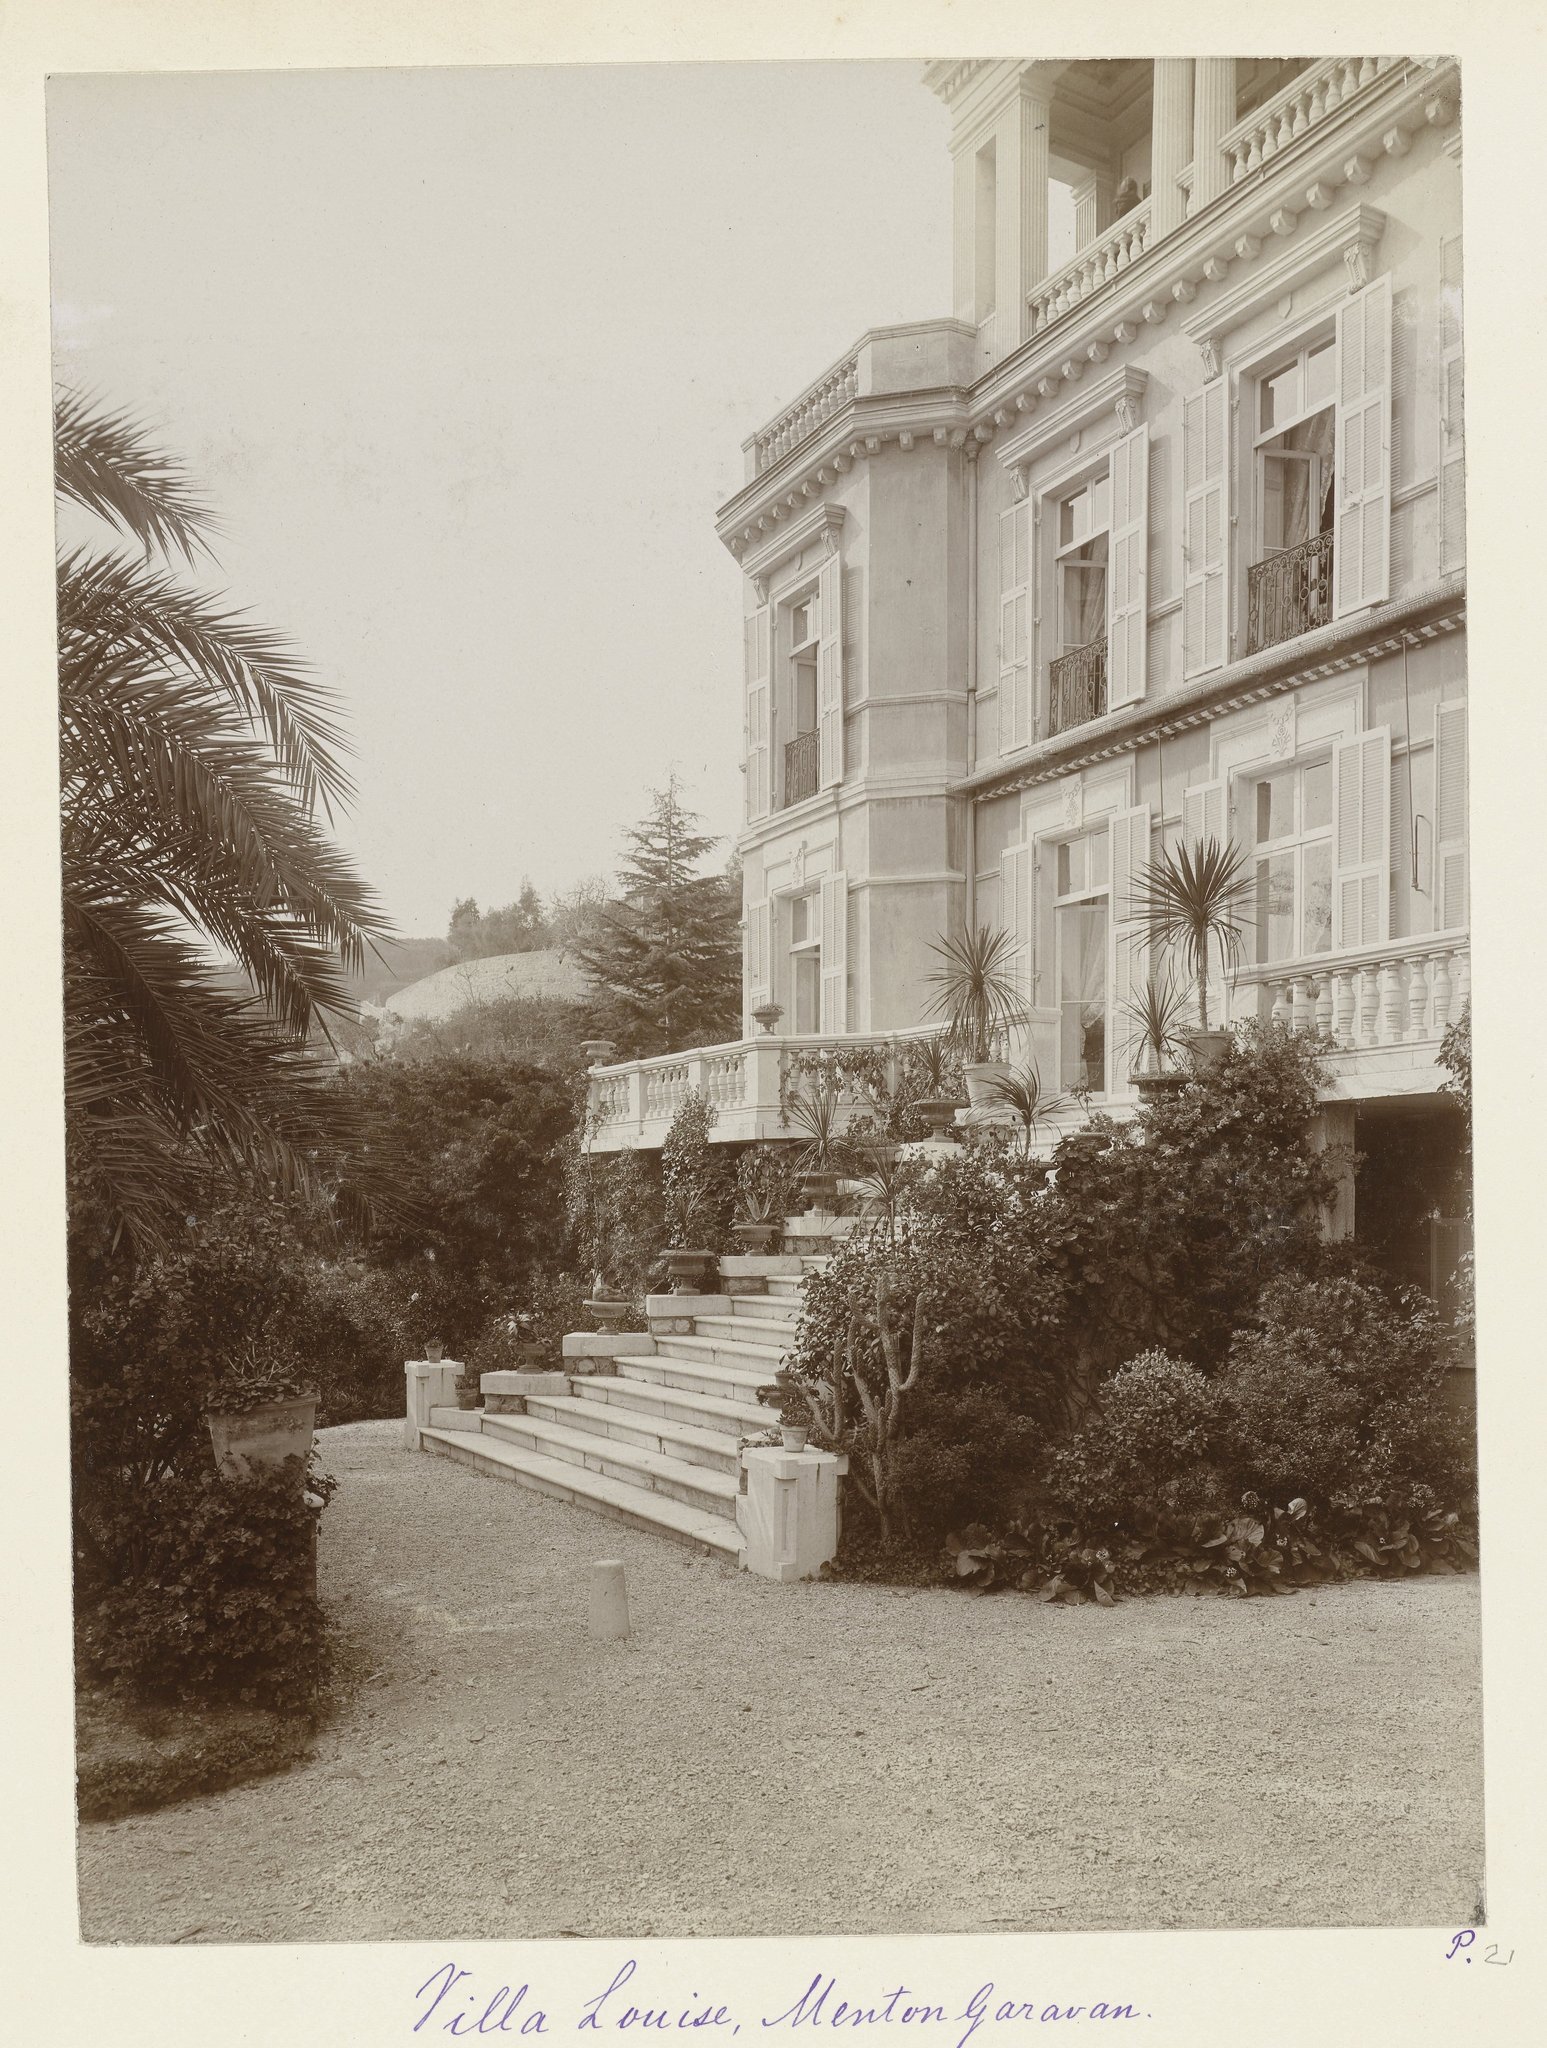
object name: photograph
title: De entree naar de tuin van het huis Villa Louise in Menton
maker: henry pauw van wieldrecht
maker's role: fotograaf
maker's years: 1863-1912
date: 1886-1896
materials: cardboard, photographic support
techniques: albumen print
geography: france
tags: menton